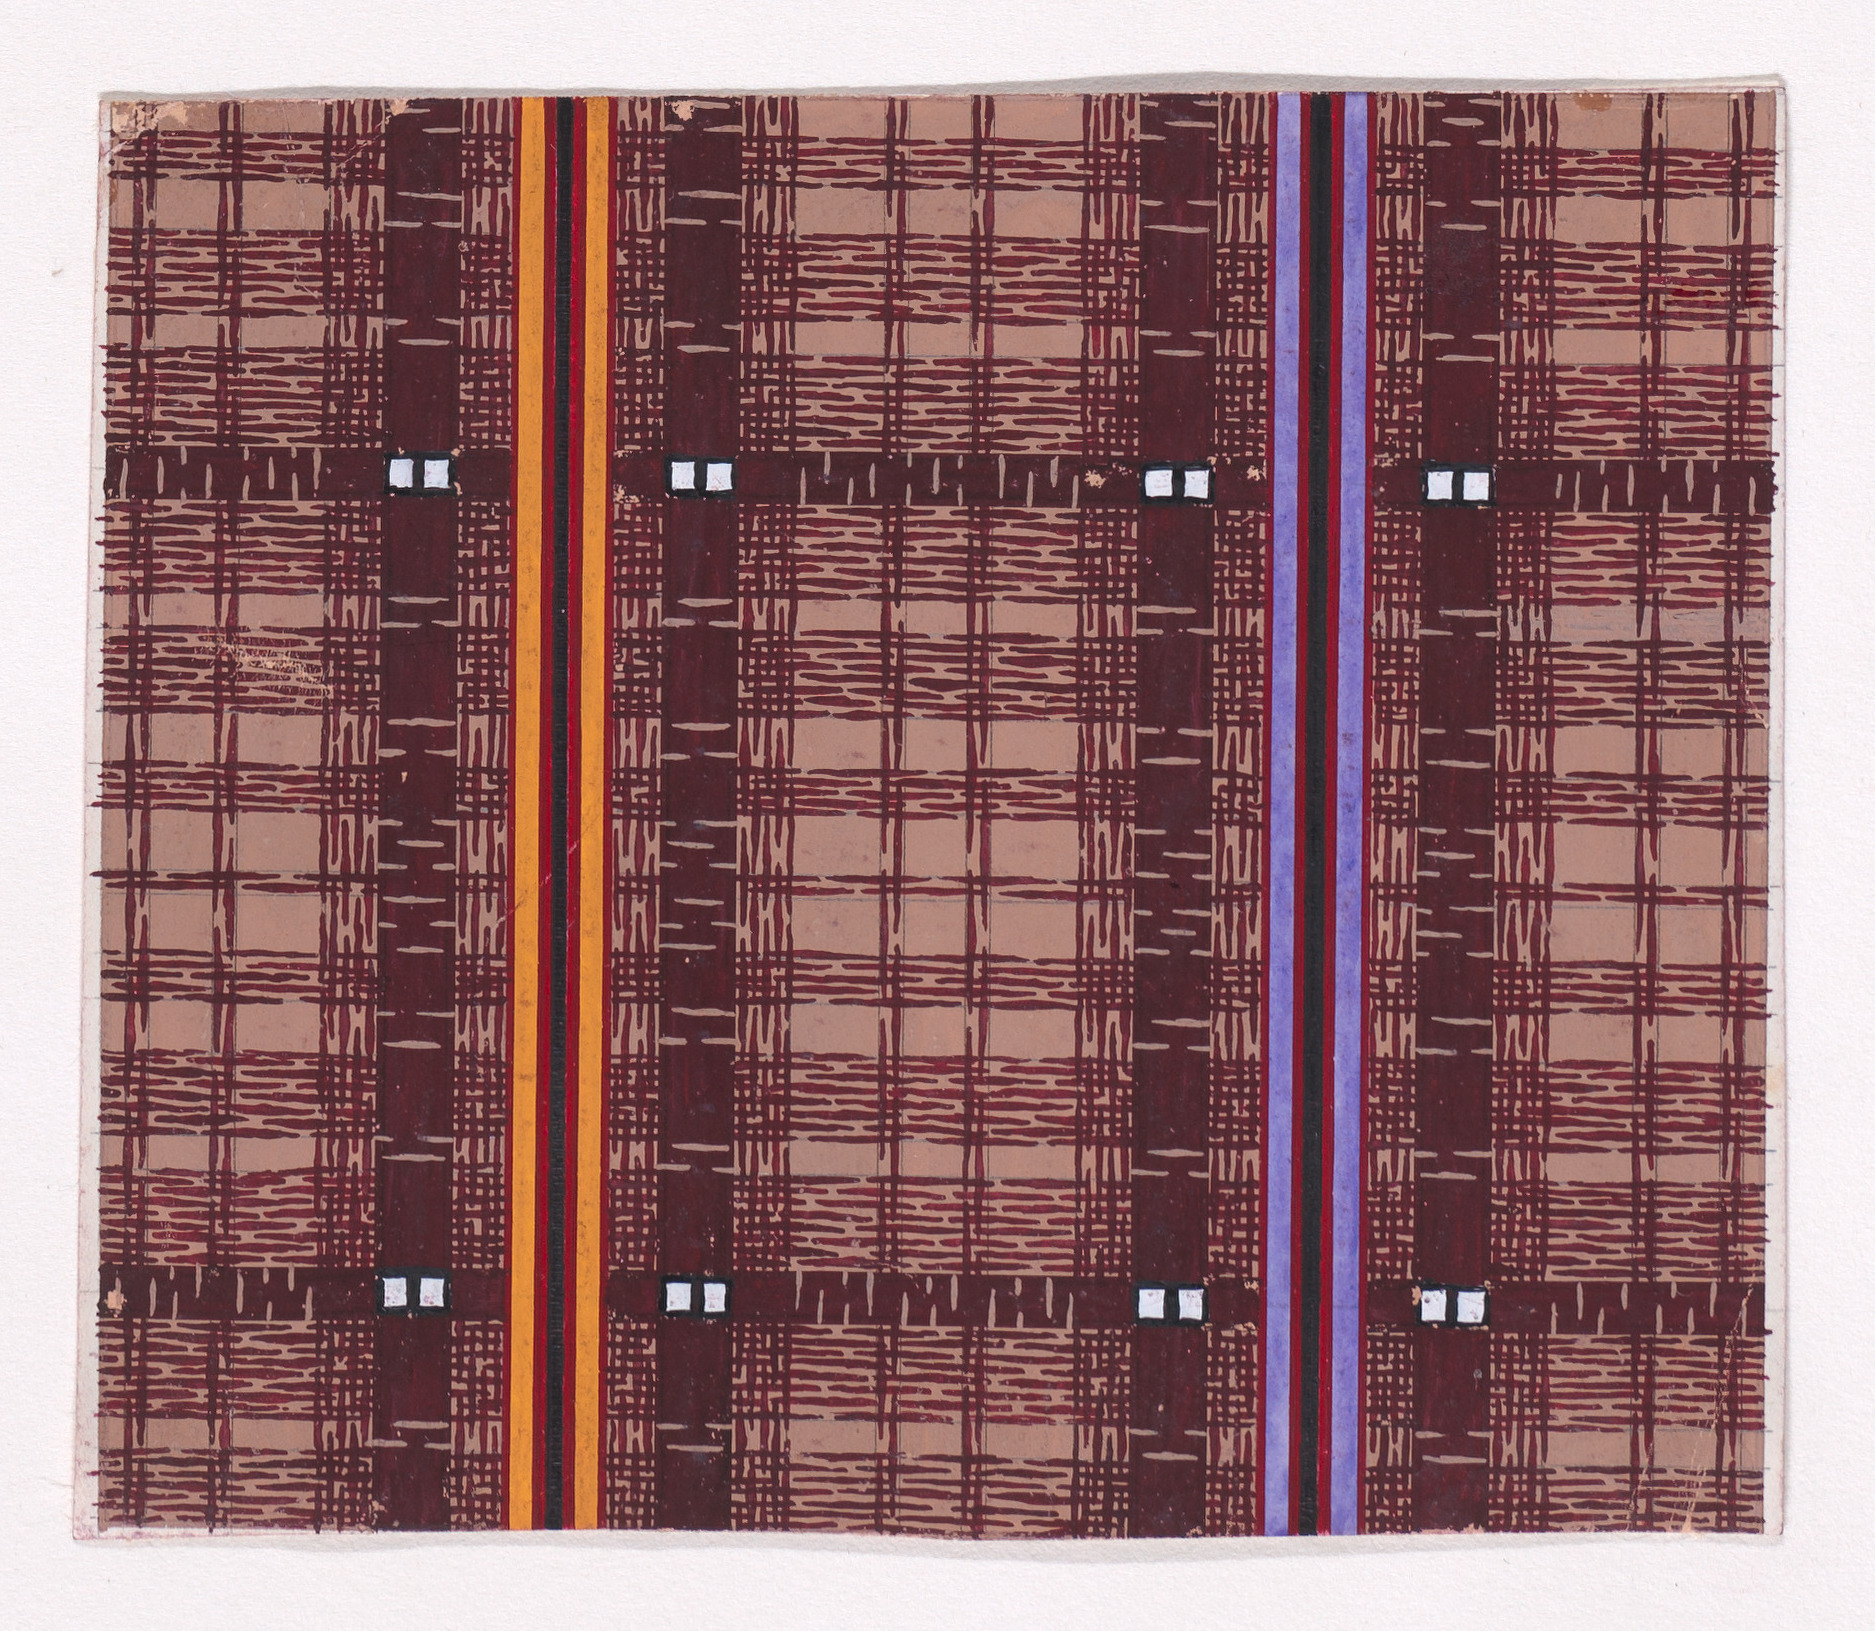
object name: drawing ornament architecture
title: Textile Design with Tartan Background and Vertical Stripes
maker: anonymous, alsatian, 19th century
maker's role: artist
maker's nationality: alsatian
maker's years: 1800-1900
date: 1840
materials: gouache